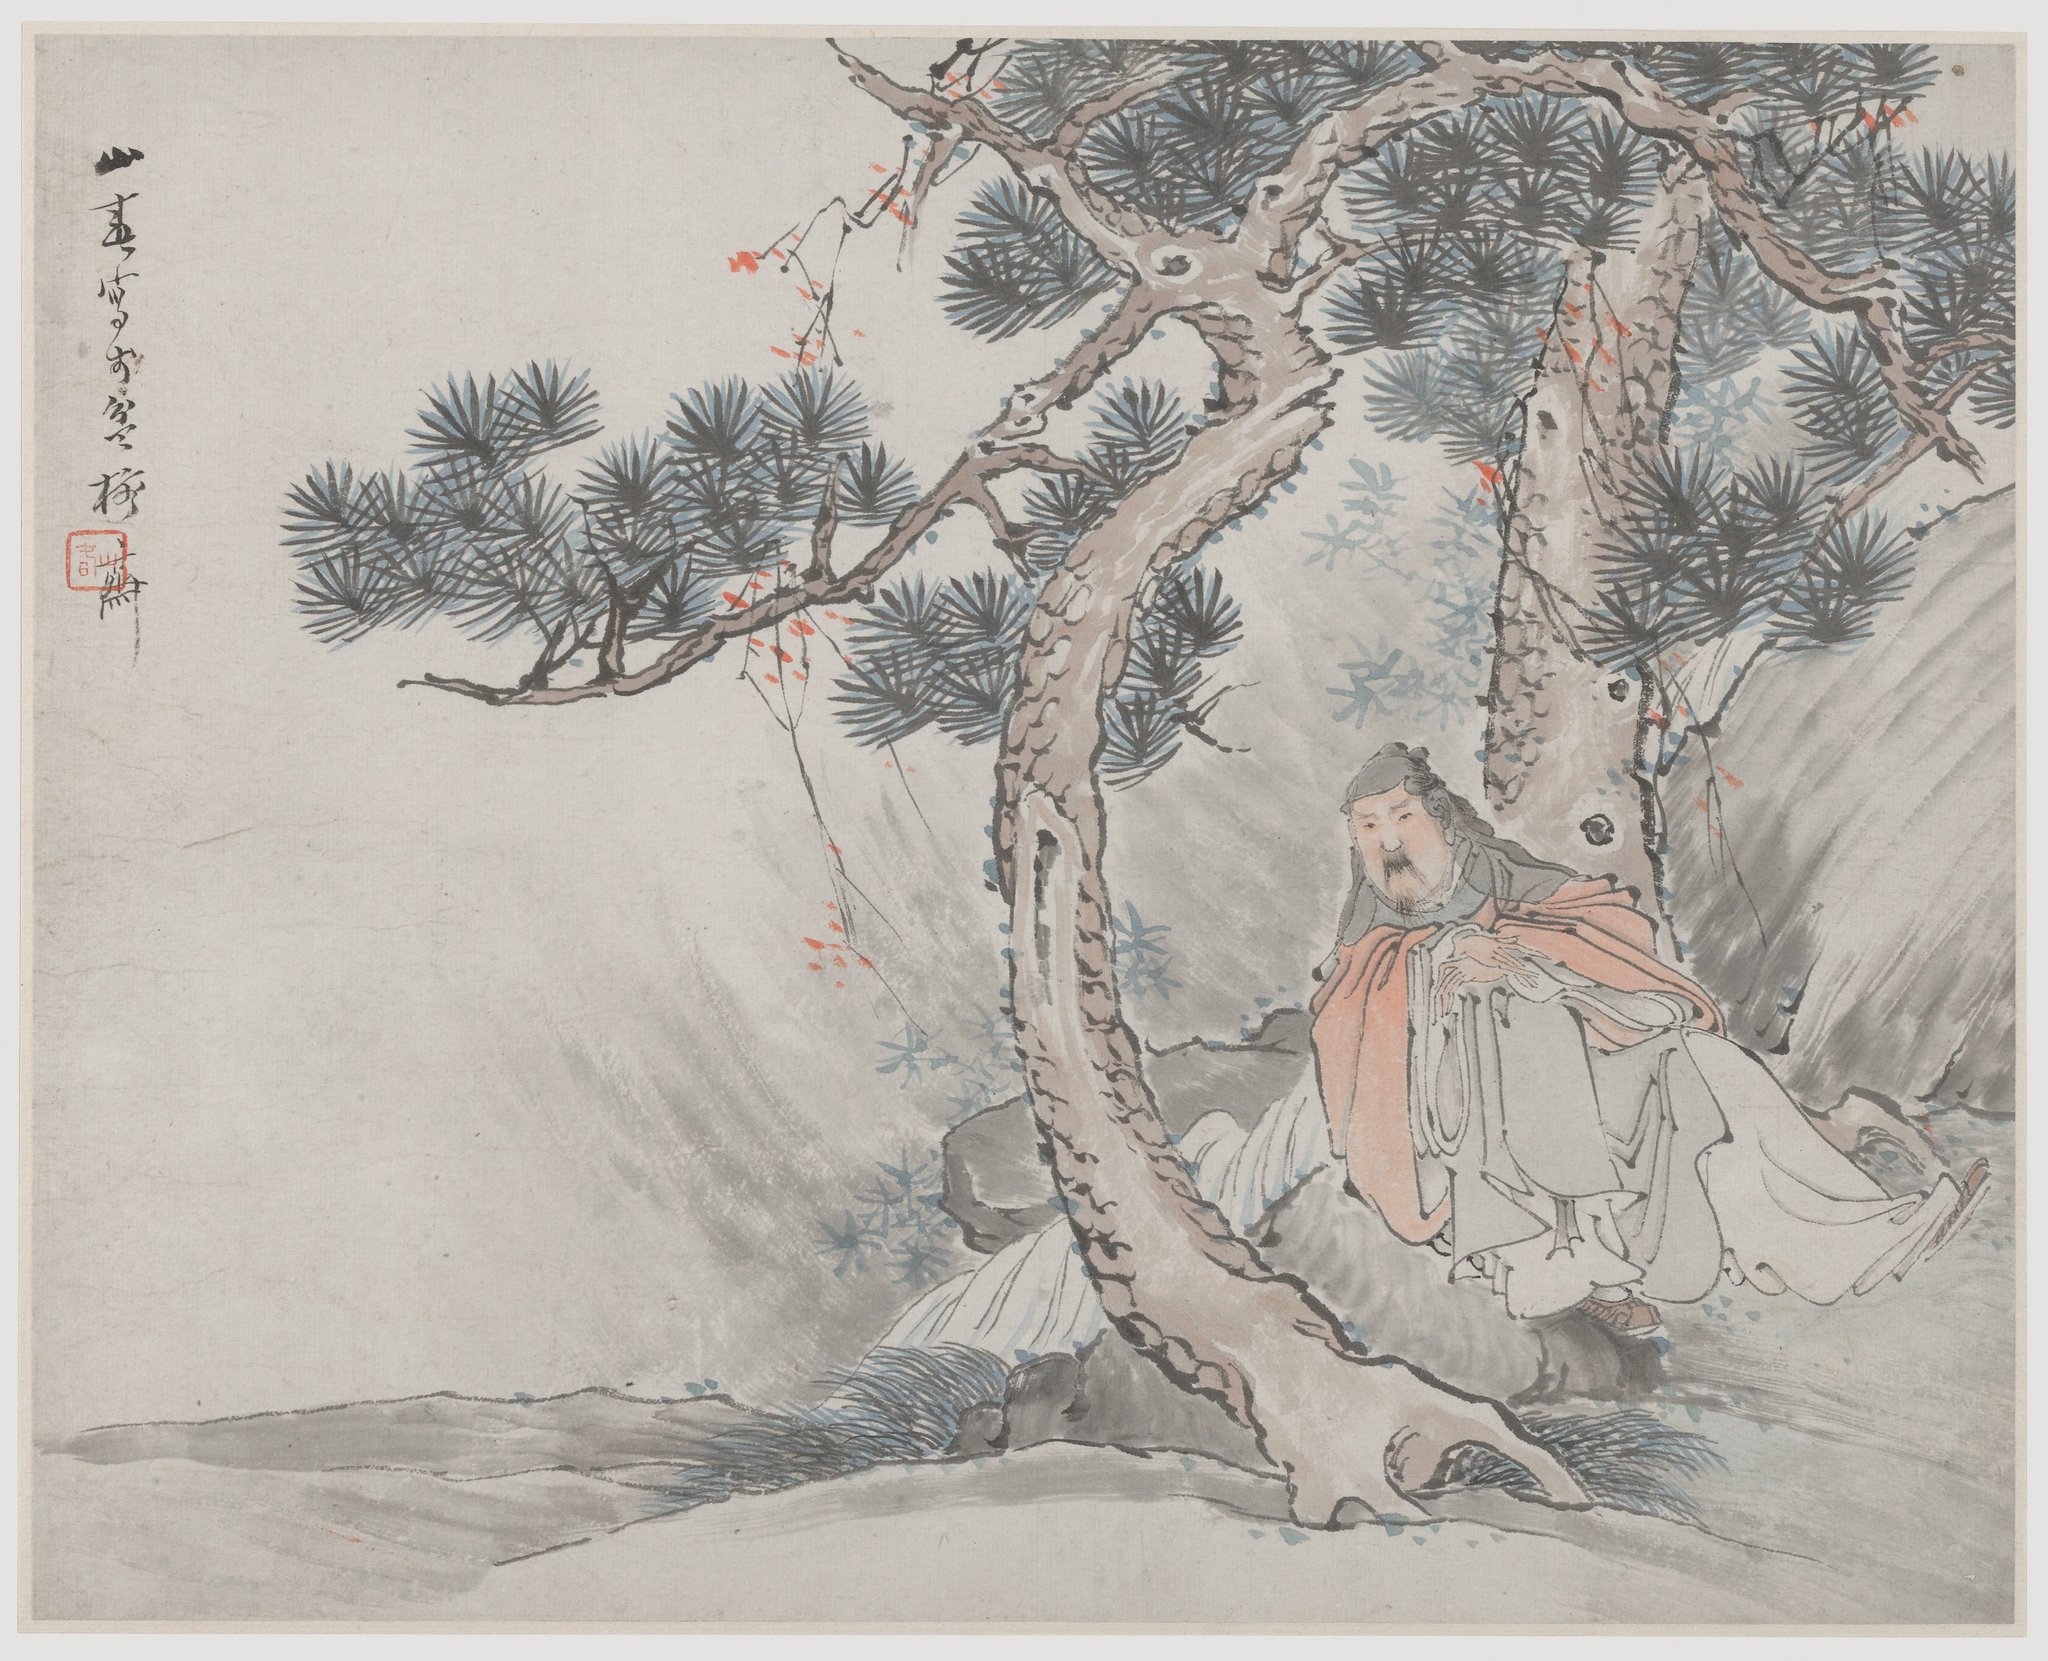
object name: framed album leaf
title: Scholar in Landscape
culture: chinese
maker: sha fu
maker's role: artist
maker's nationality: chinese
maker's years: 1831-1906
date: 1831-1906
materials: ink, paper